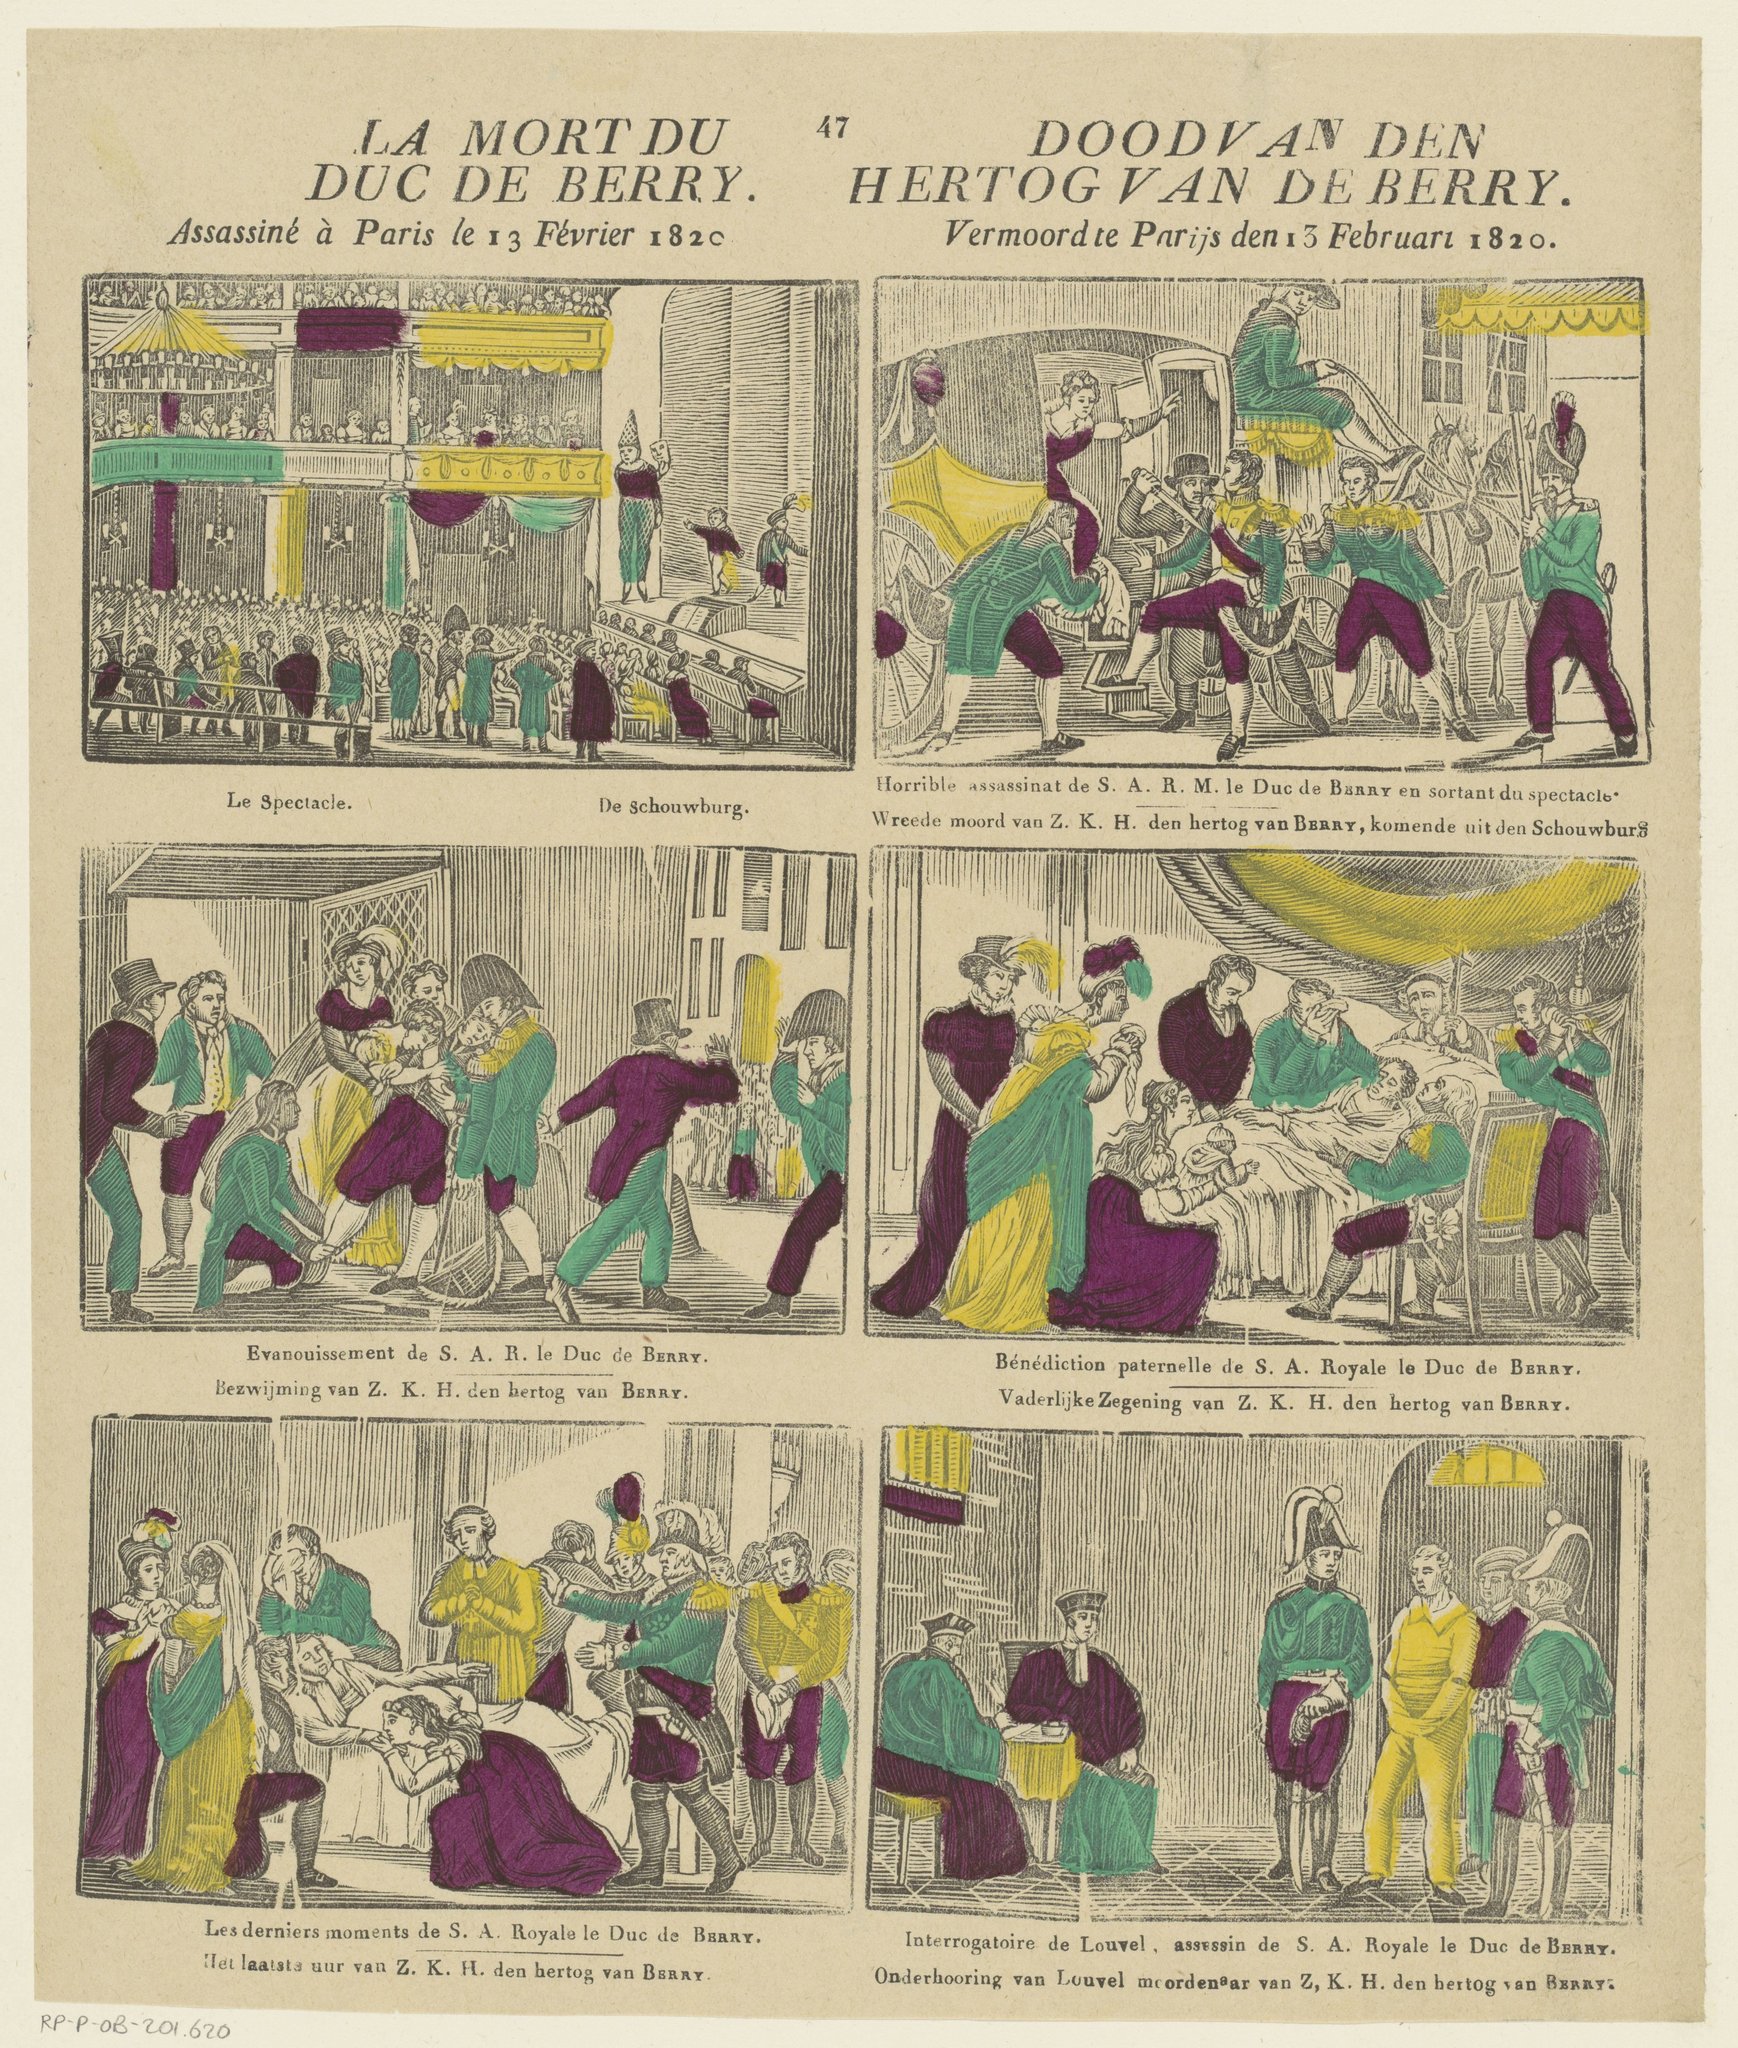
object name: print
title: La mort du / Duc de Berry. / Assassiné à Paris le 13 Février 1820 / Dood van den / Hertog van de Berry. / Vermoord te Parijs den 13 Februari 1820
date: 1800-1833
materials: paper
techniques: colour, letterpress printing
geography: turnhout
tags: extreme unction ~ the last of the seven sacraments, theatre (building), murder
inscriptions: collector's mark: Lugt 2760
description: Blad met 6 voorstellingen over de moord op Karel Ferdinand van Berry op 13 februari 1820 te Parijs. Onder elke voorstelling een onderschrift in het Nederlands en in het Frans. Genummerd midden boven: 47